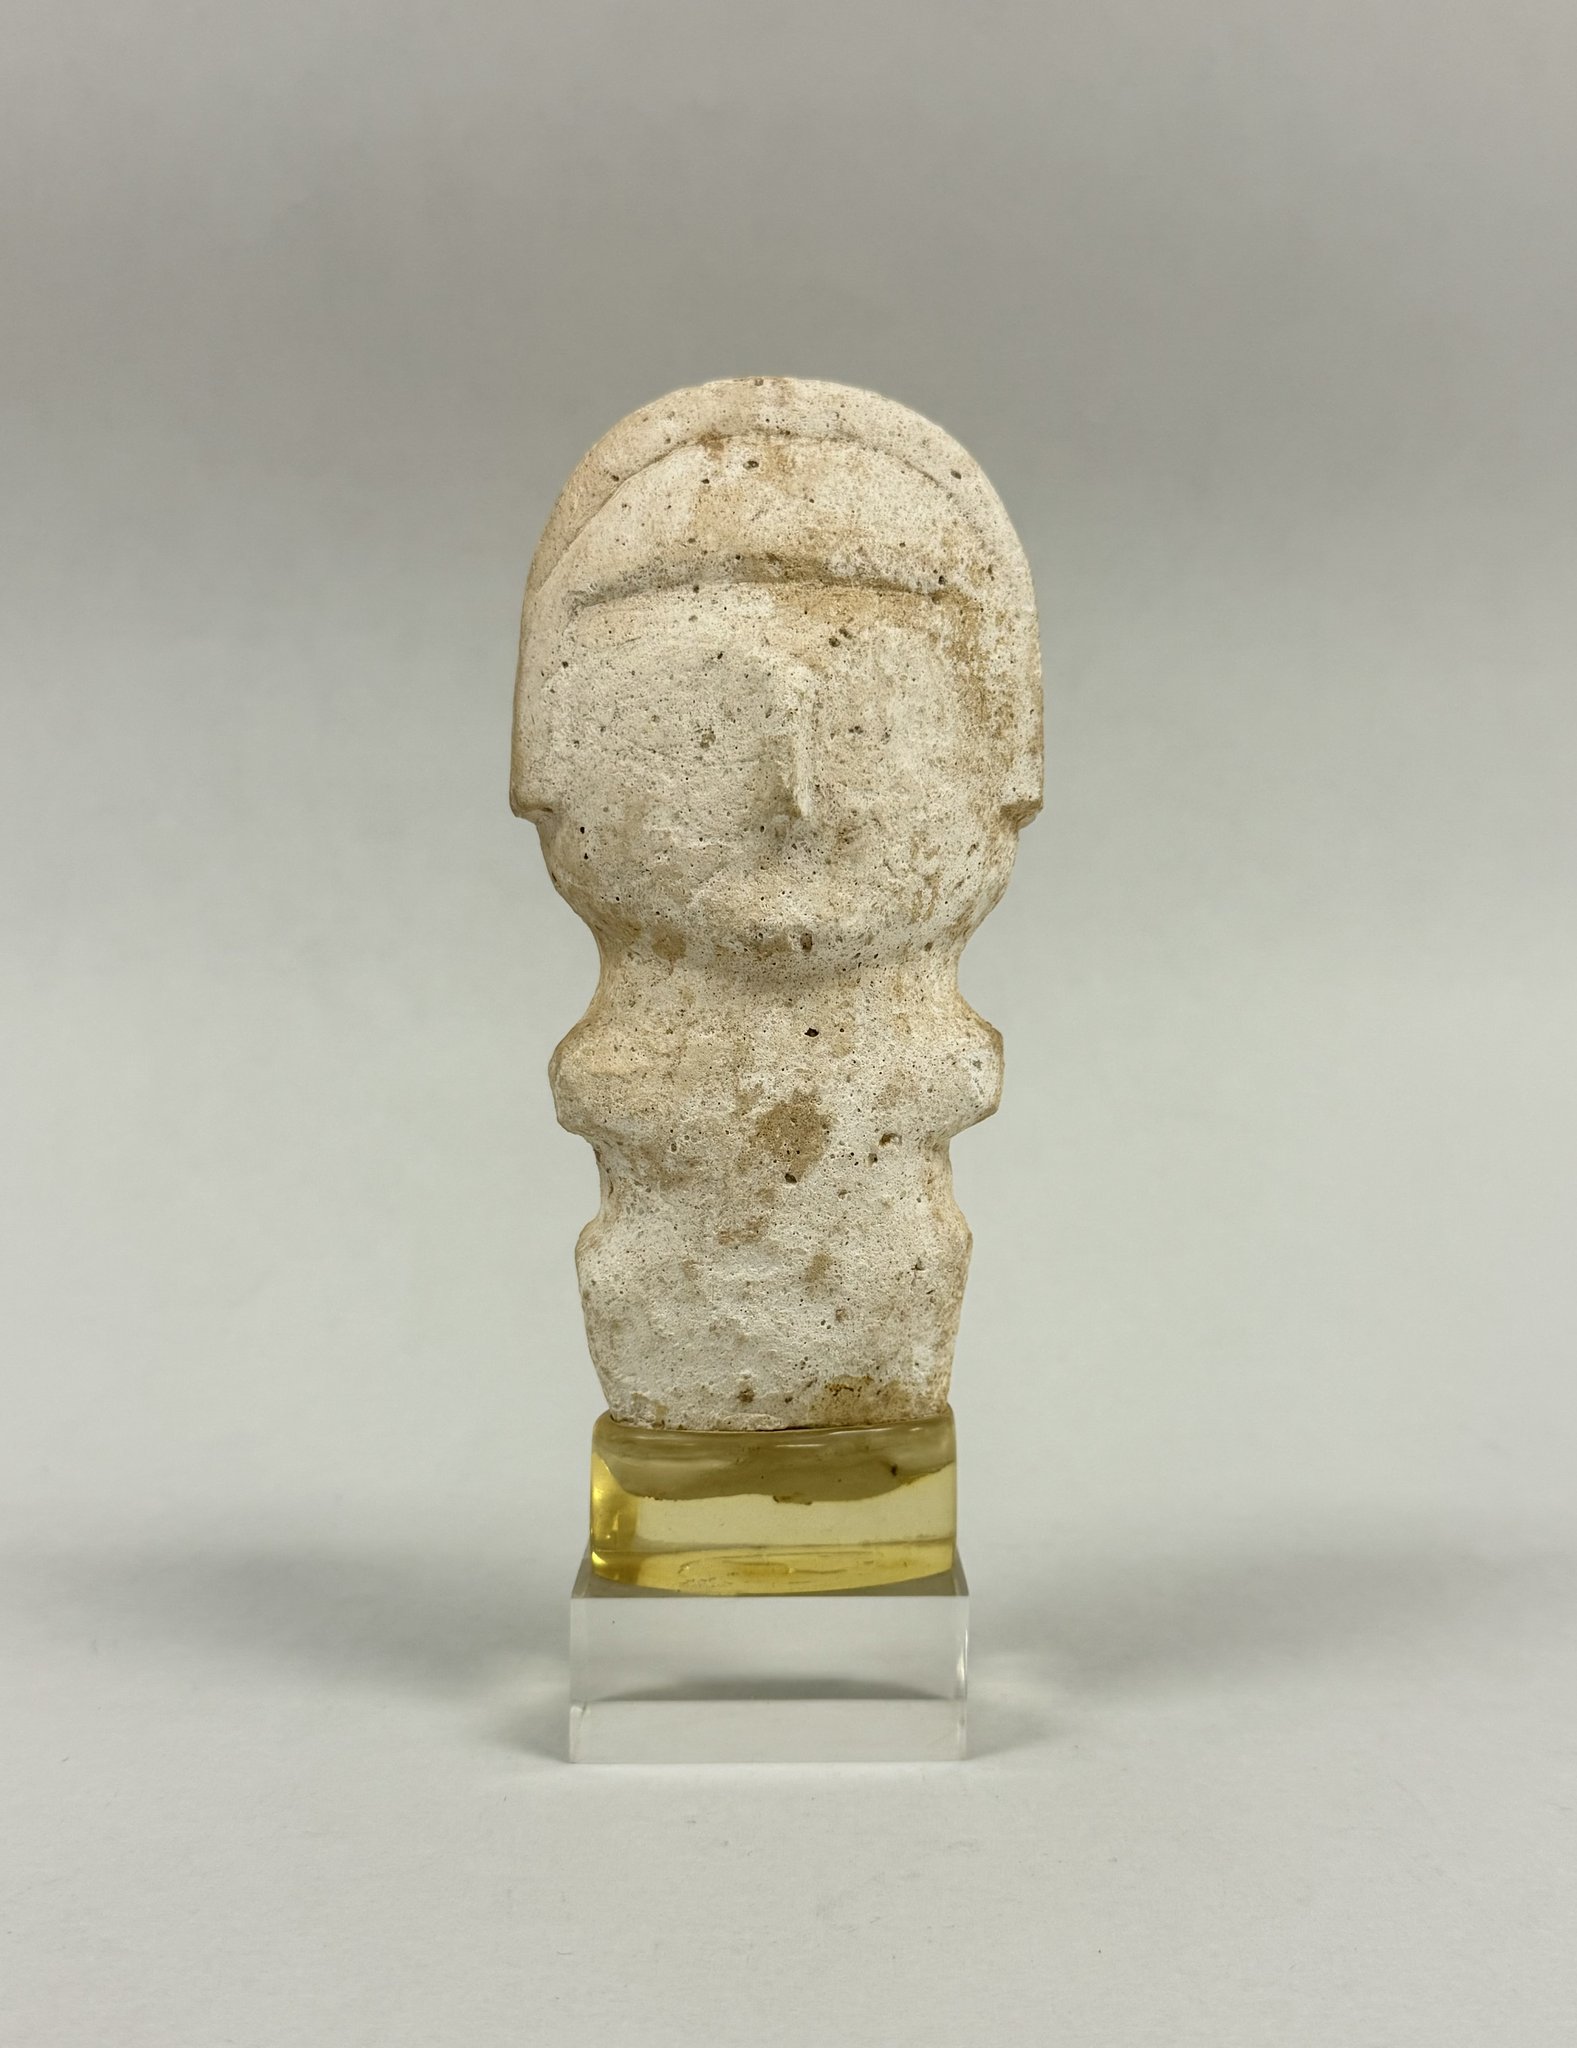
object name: figure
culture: indonesian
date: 500 BCE-300 CE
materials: stone